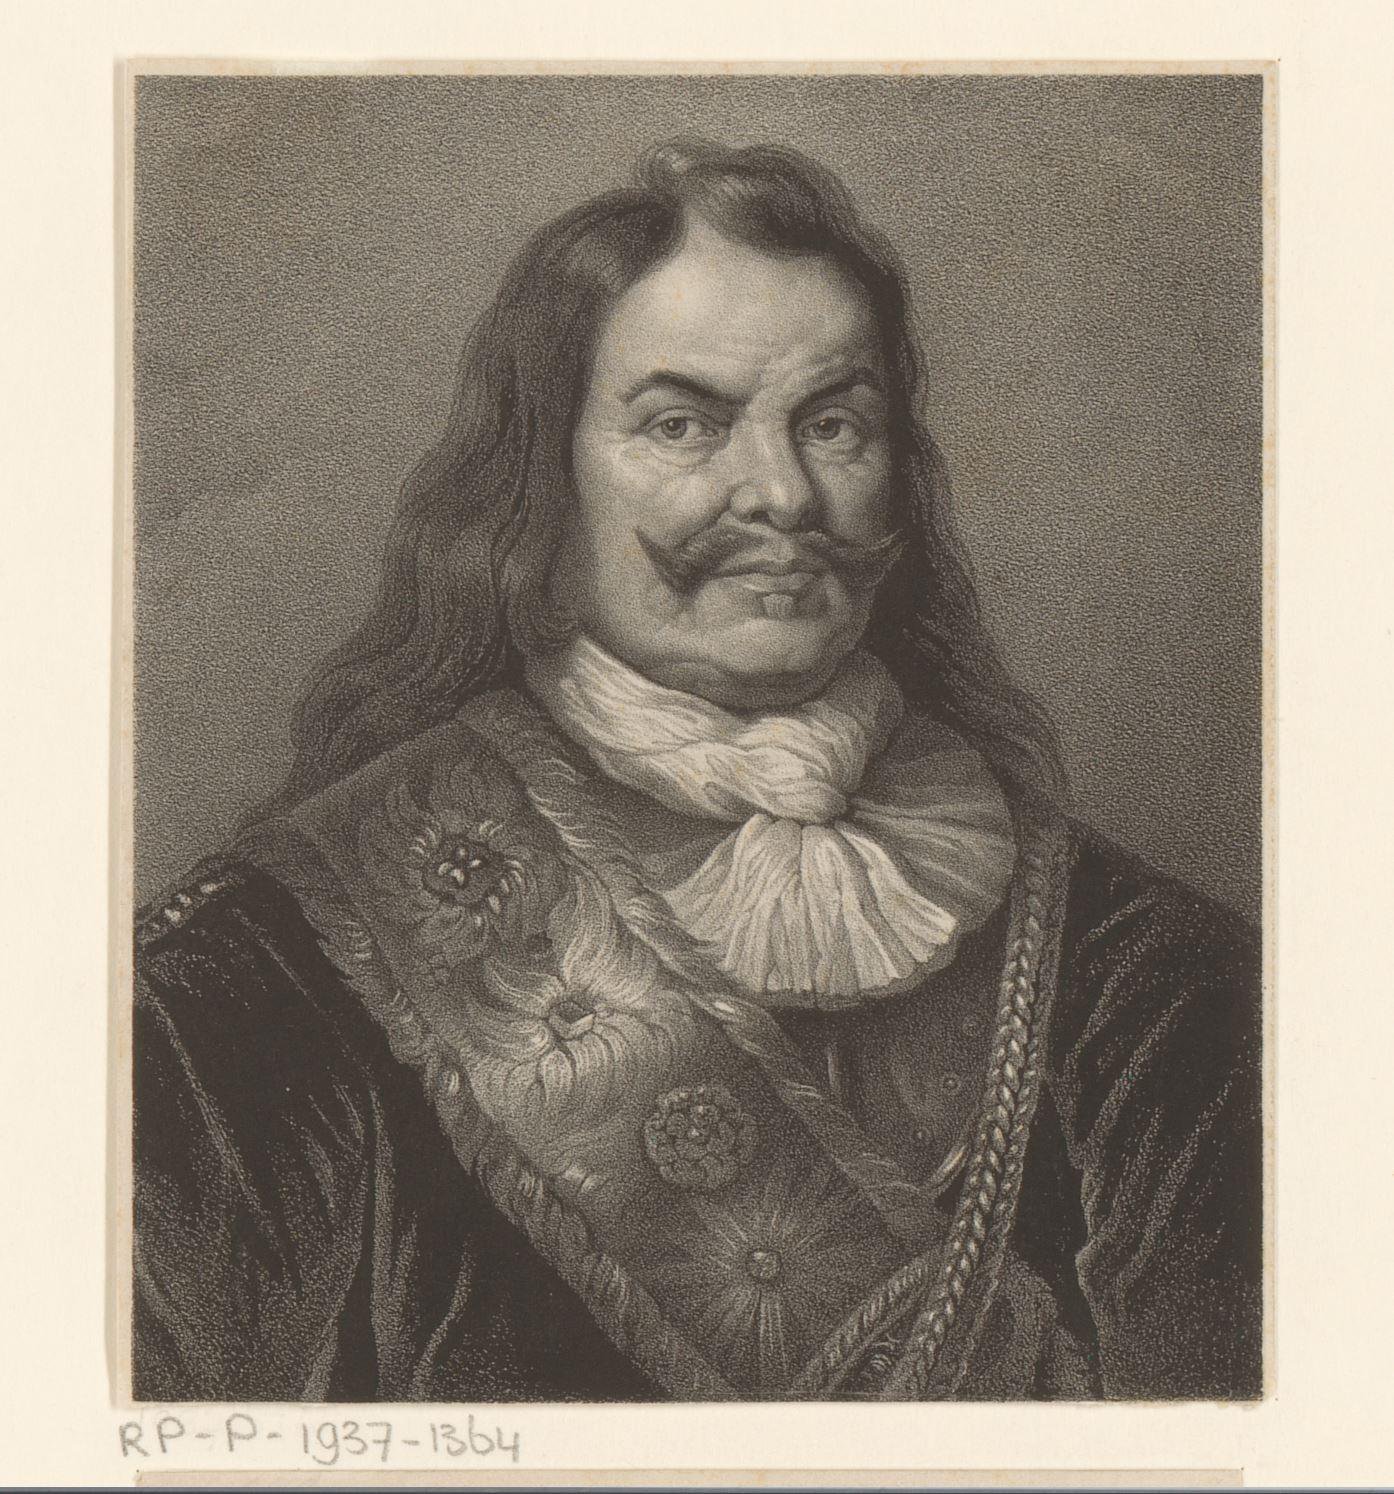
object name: print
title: Portret van Michiel Adriaenszoon de Ruyter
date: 1833-1863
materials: paper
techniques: lithograph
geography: the hague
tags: michiel adriaenszoon de ruyter, historical persons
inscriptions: collector's mark: Lugt 2228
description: Los onder het portret de signatuur van de geportretteerde.